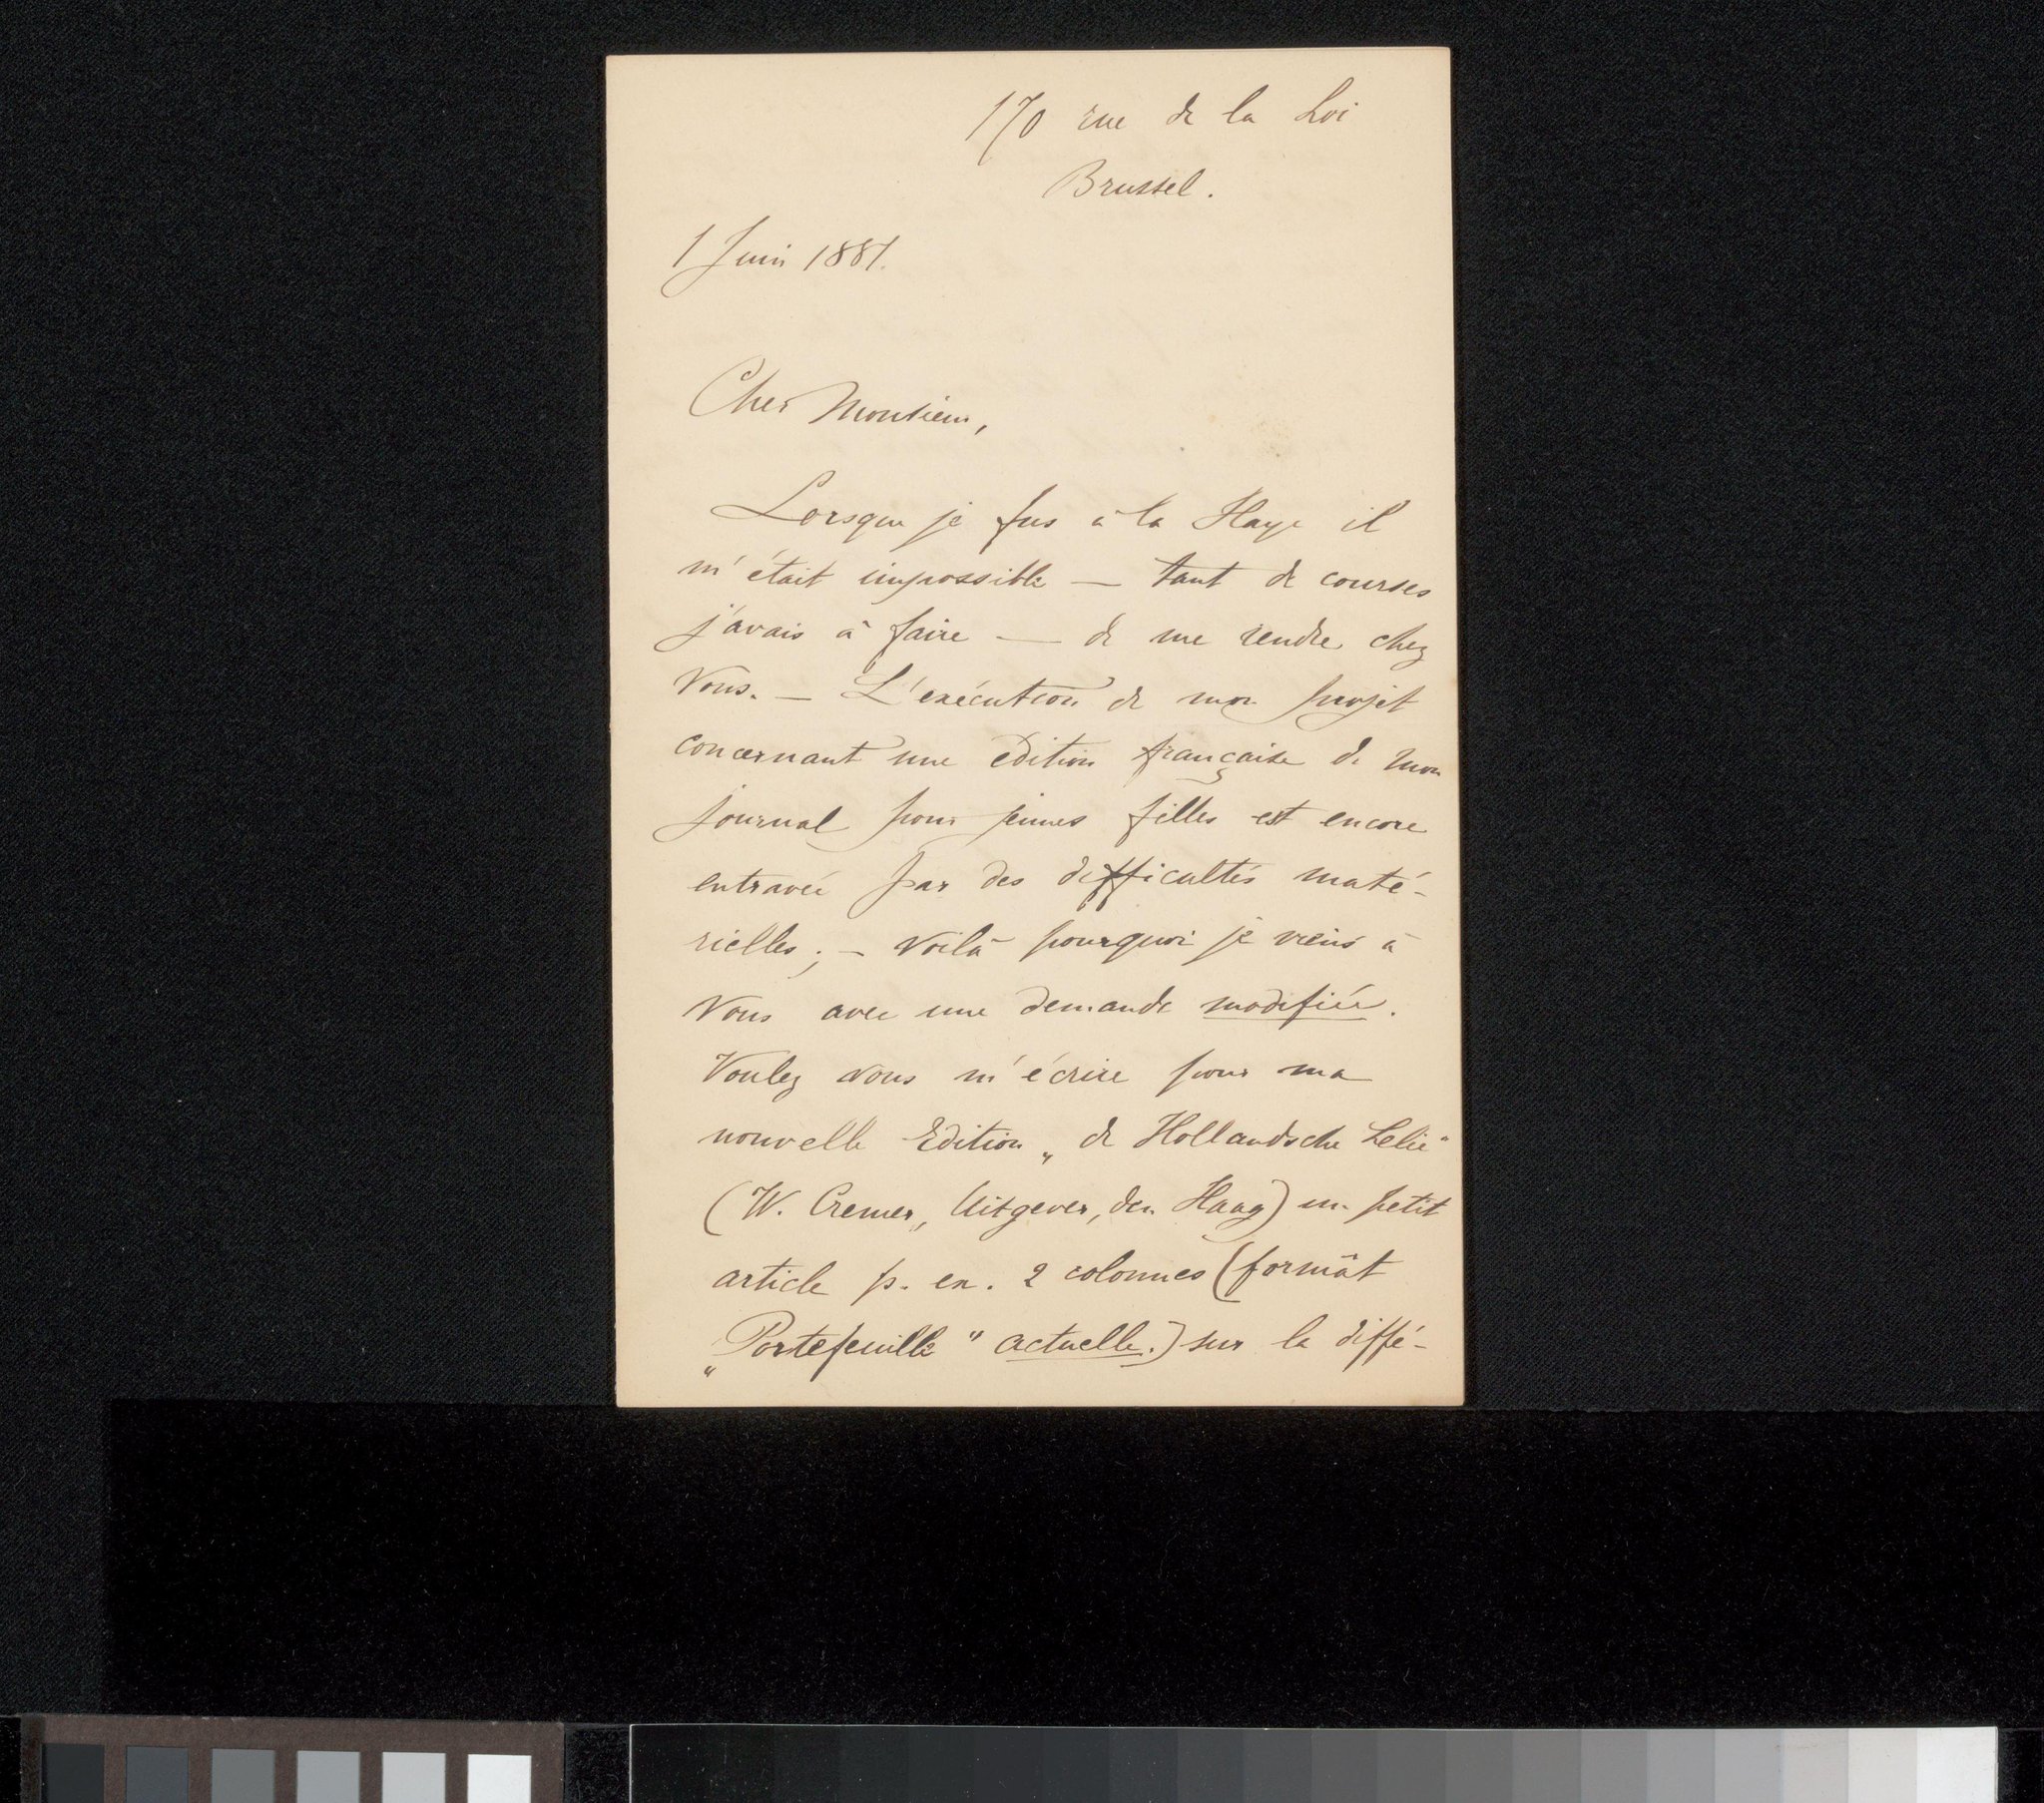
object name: letter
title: Brief aan Philip Zilcken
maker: catharina alberdingk thijm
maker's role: schrijver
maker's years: 1848-1908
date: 1887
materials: ink, paper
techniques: pen, writing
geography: brussels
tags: the hague, draughtsman, philip zilcken, painting (including book-illumination, miniature-painting), printed matter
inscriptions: collector's mark: ‘RPK’